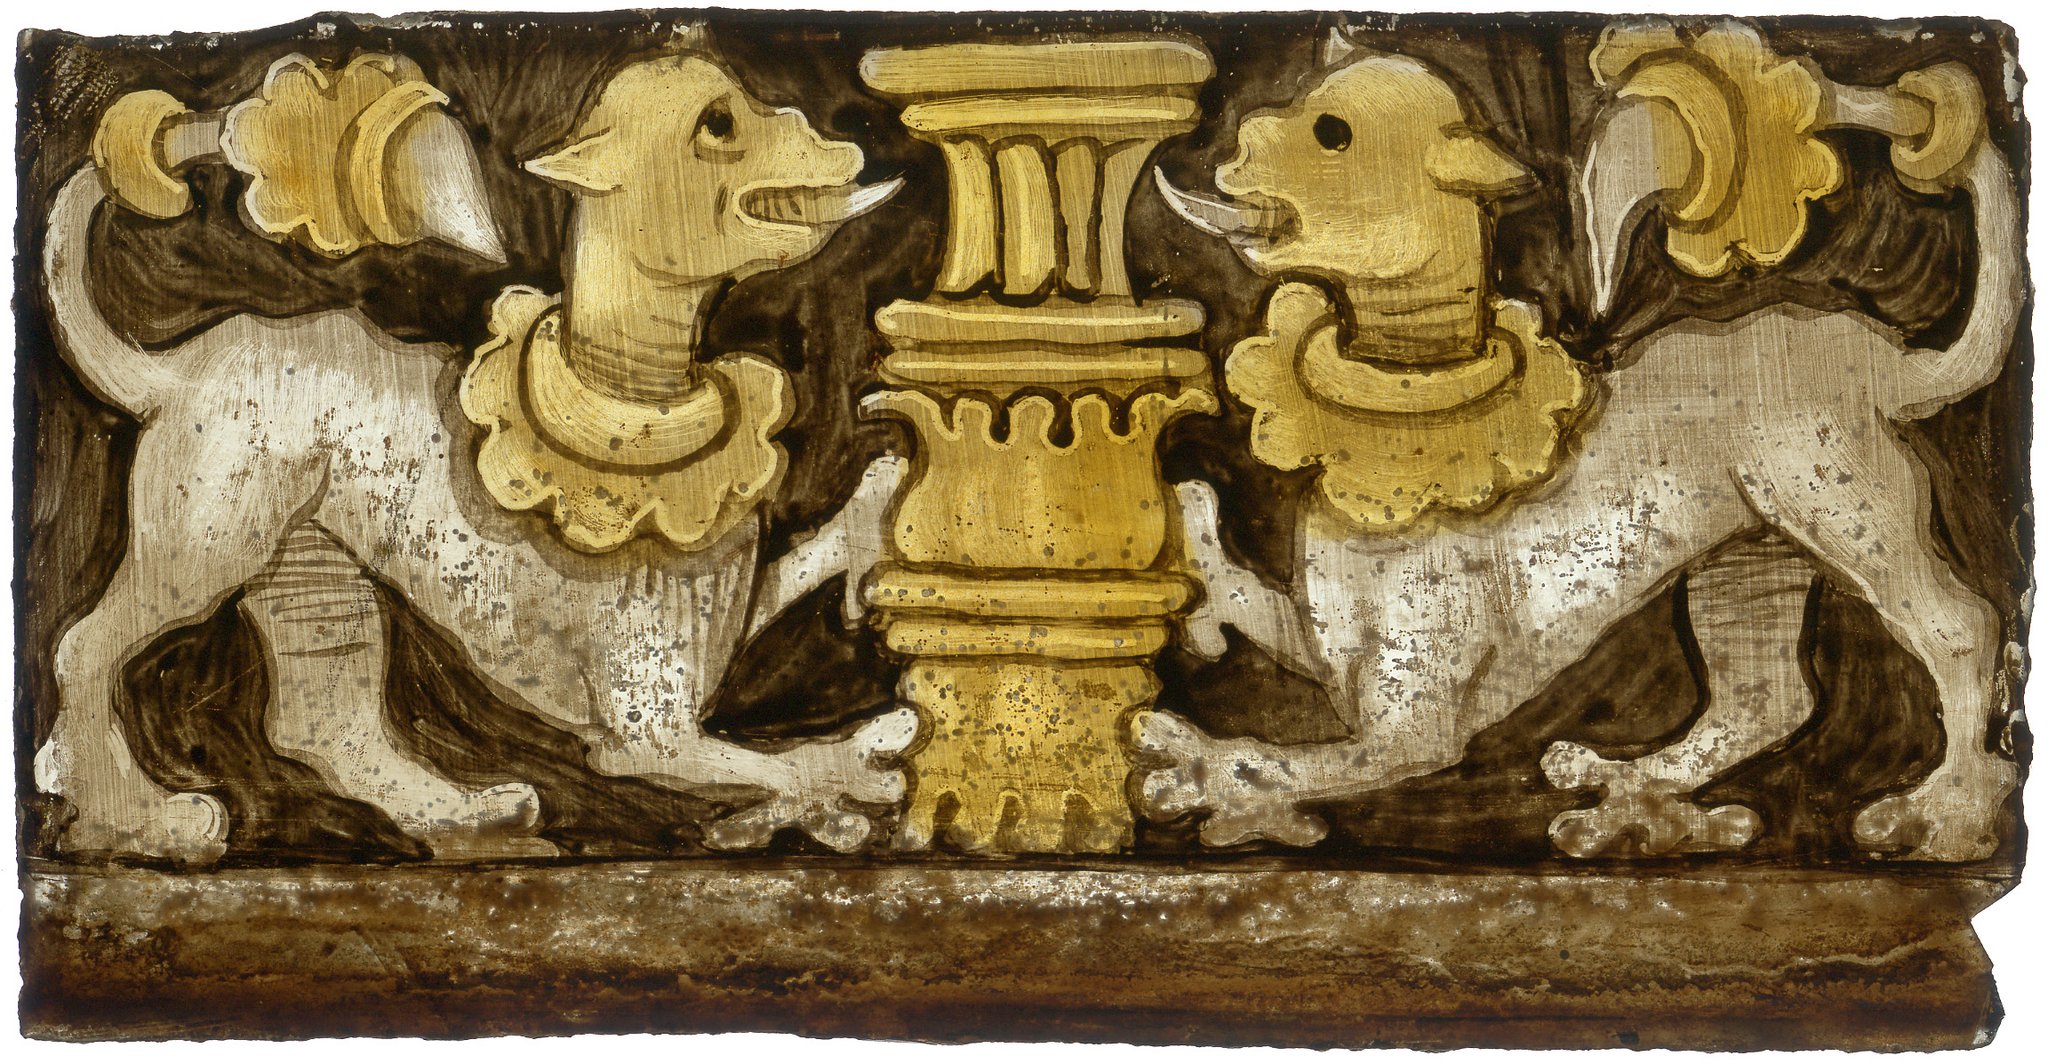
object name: border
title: Border fragment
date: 1501-1600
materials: glass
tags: griffins